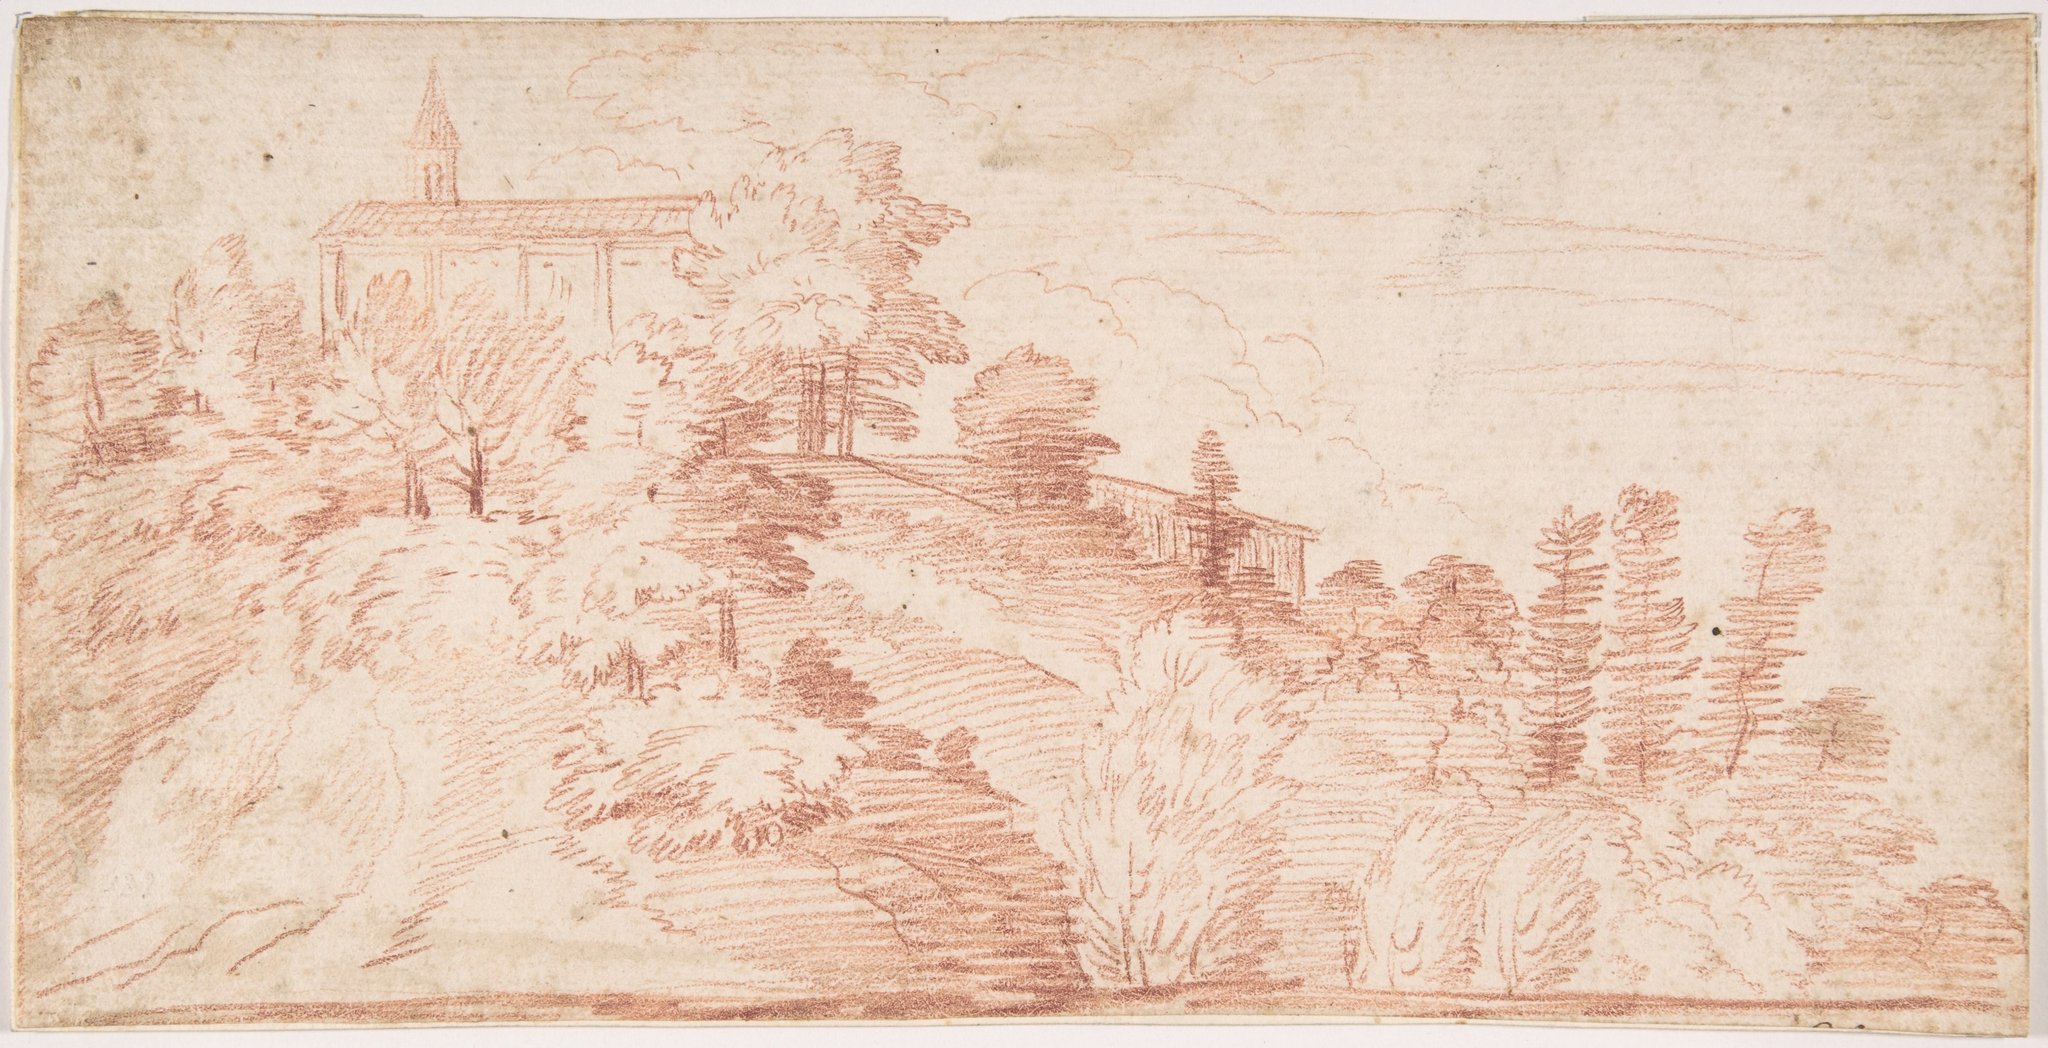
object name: drawing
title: Landscape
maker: giovanni larciani ("master of the kress landscapes")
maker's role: artist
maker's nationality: italian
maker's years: 1484-1527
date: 1501-1600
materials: chalk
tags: houses,towers,landscapes,trees